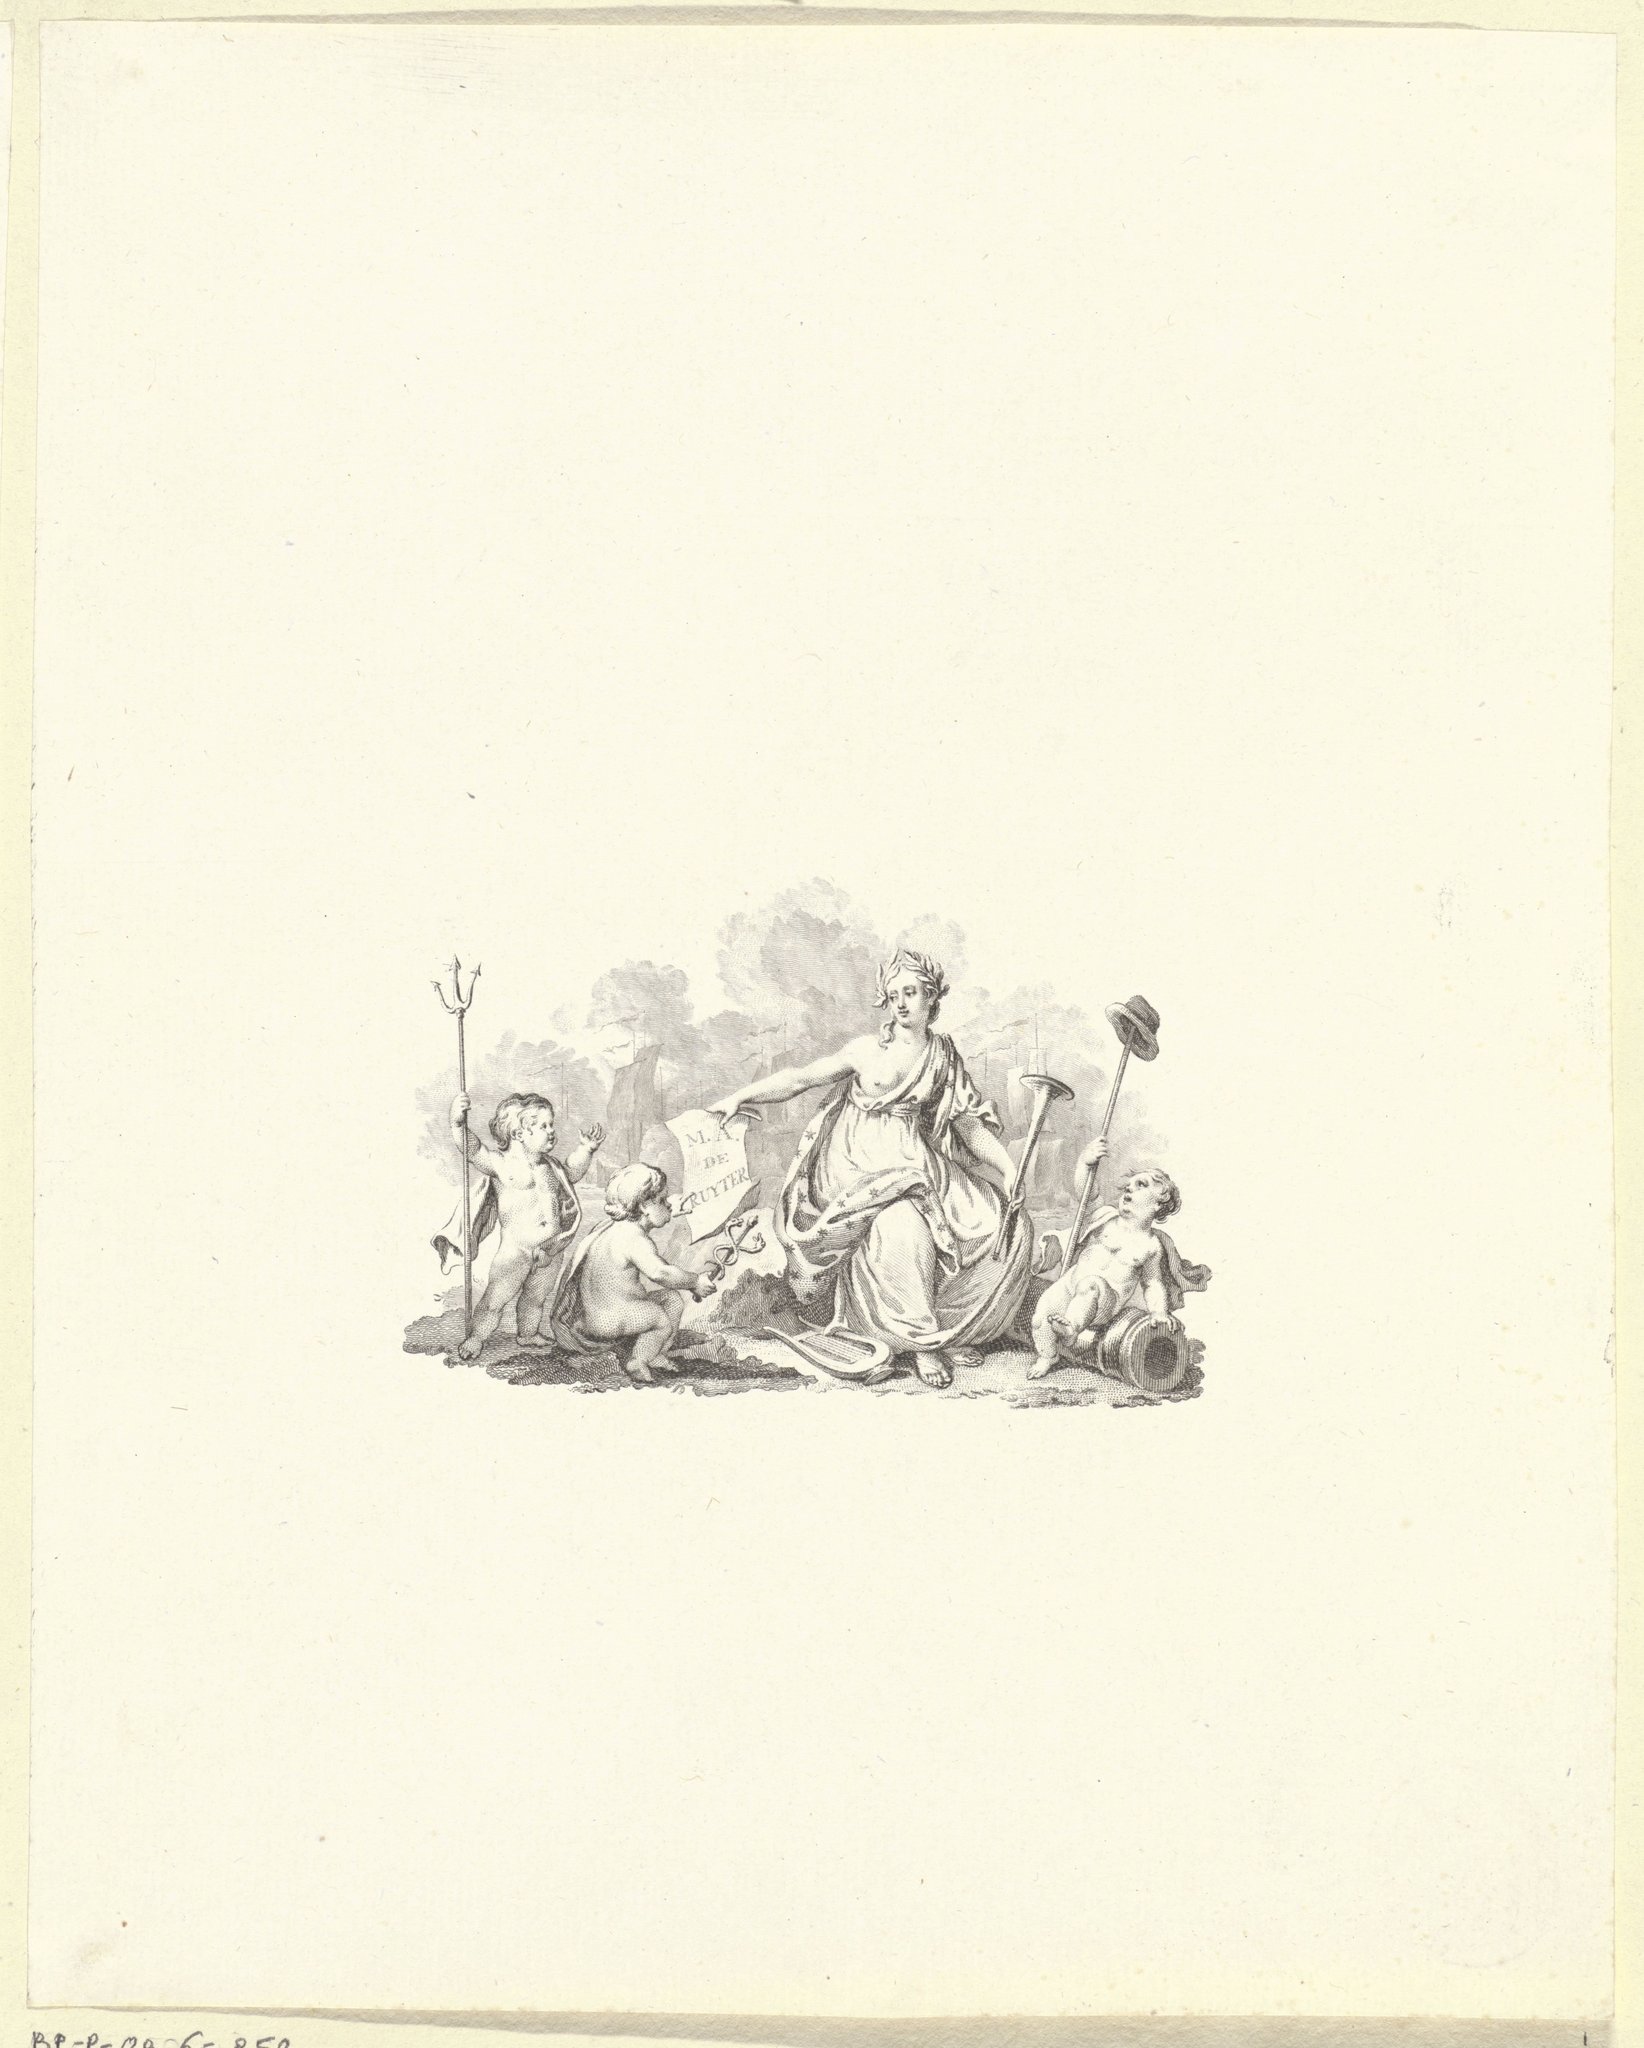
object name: print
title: Titelpagina voor: Adriaan Pietersz. Loosjes., 'M.A. De Ruyter, in X Boeken', 1784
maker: reinier vinkeles (i)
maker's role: draughtsman, print maker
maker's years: 1741-1816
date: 1784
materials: paper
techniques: engraving, etching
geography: amsterdam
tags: sailing-ship, sailing-boat, attributes of mercury, cupids: 'amores', 'amoretti', 'putti', freedom, liberty; 'libertà' (ripa) (+ symbolical representation of concept)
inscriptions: collector's mark: Lugt 240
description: Proefdruk van titelpagina voor: Loosjes, Adriaan Pietersz.. M.A. De Ruyter, in X Boeken. Amsterdam: Willem Holtrop, Haarlem: Adriaan Pietersz. Loosjes, 1784.